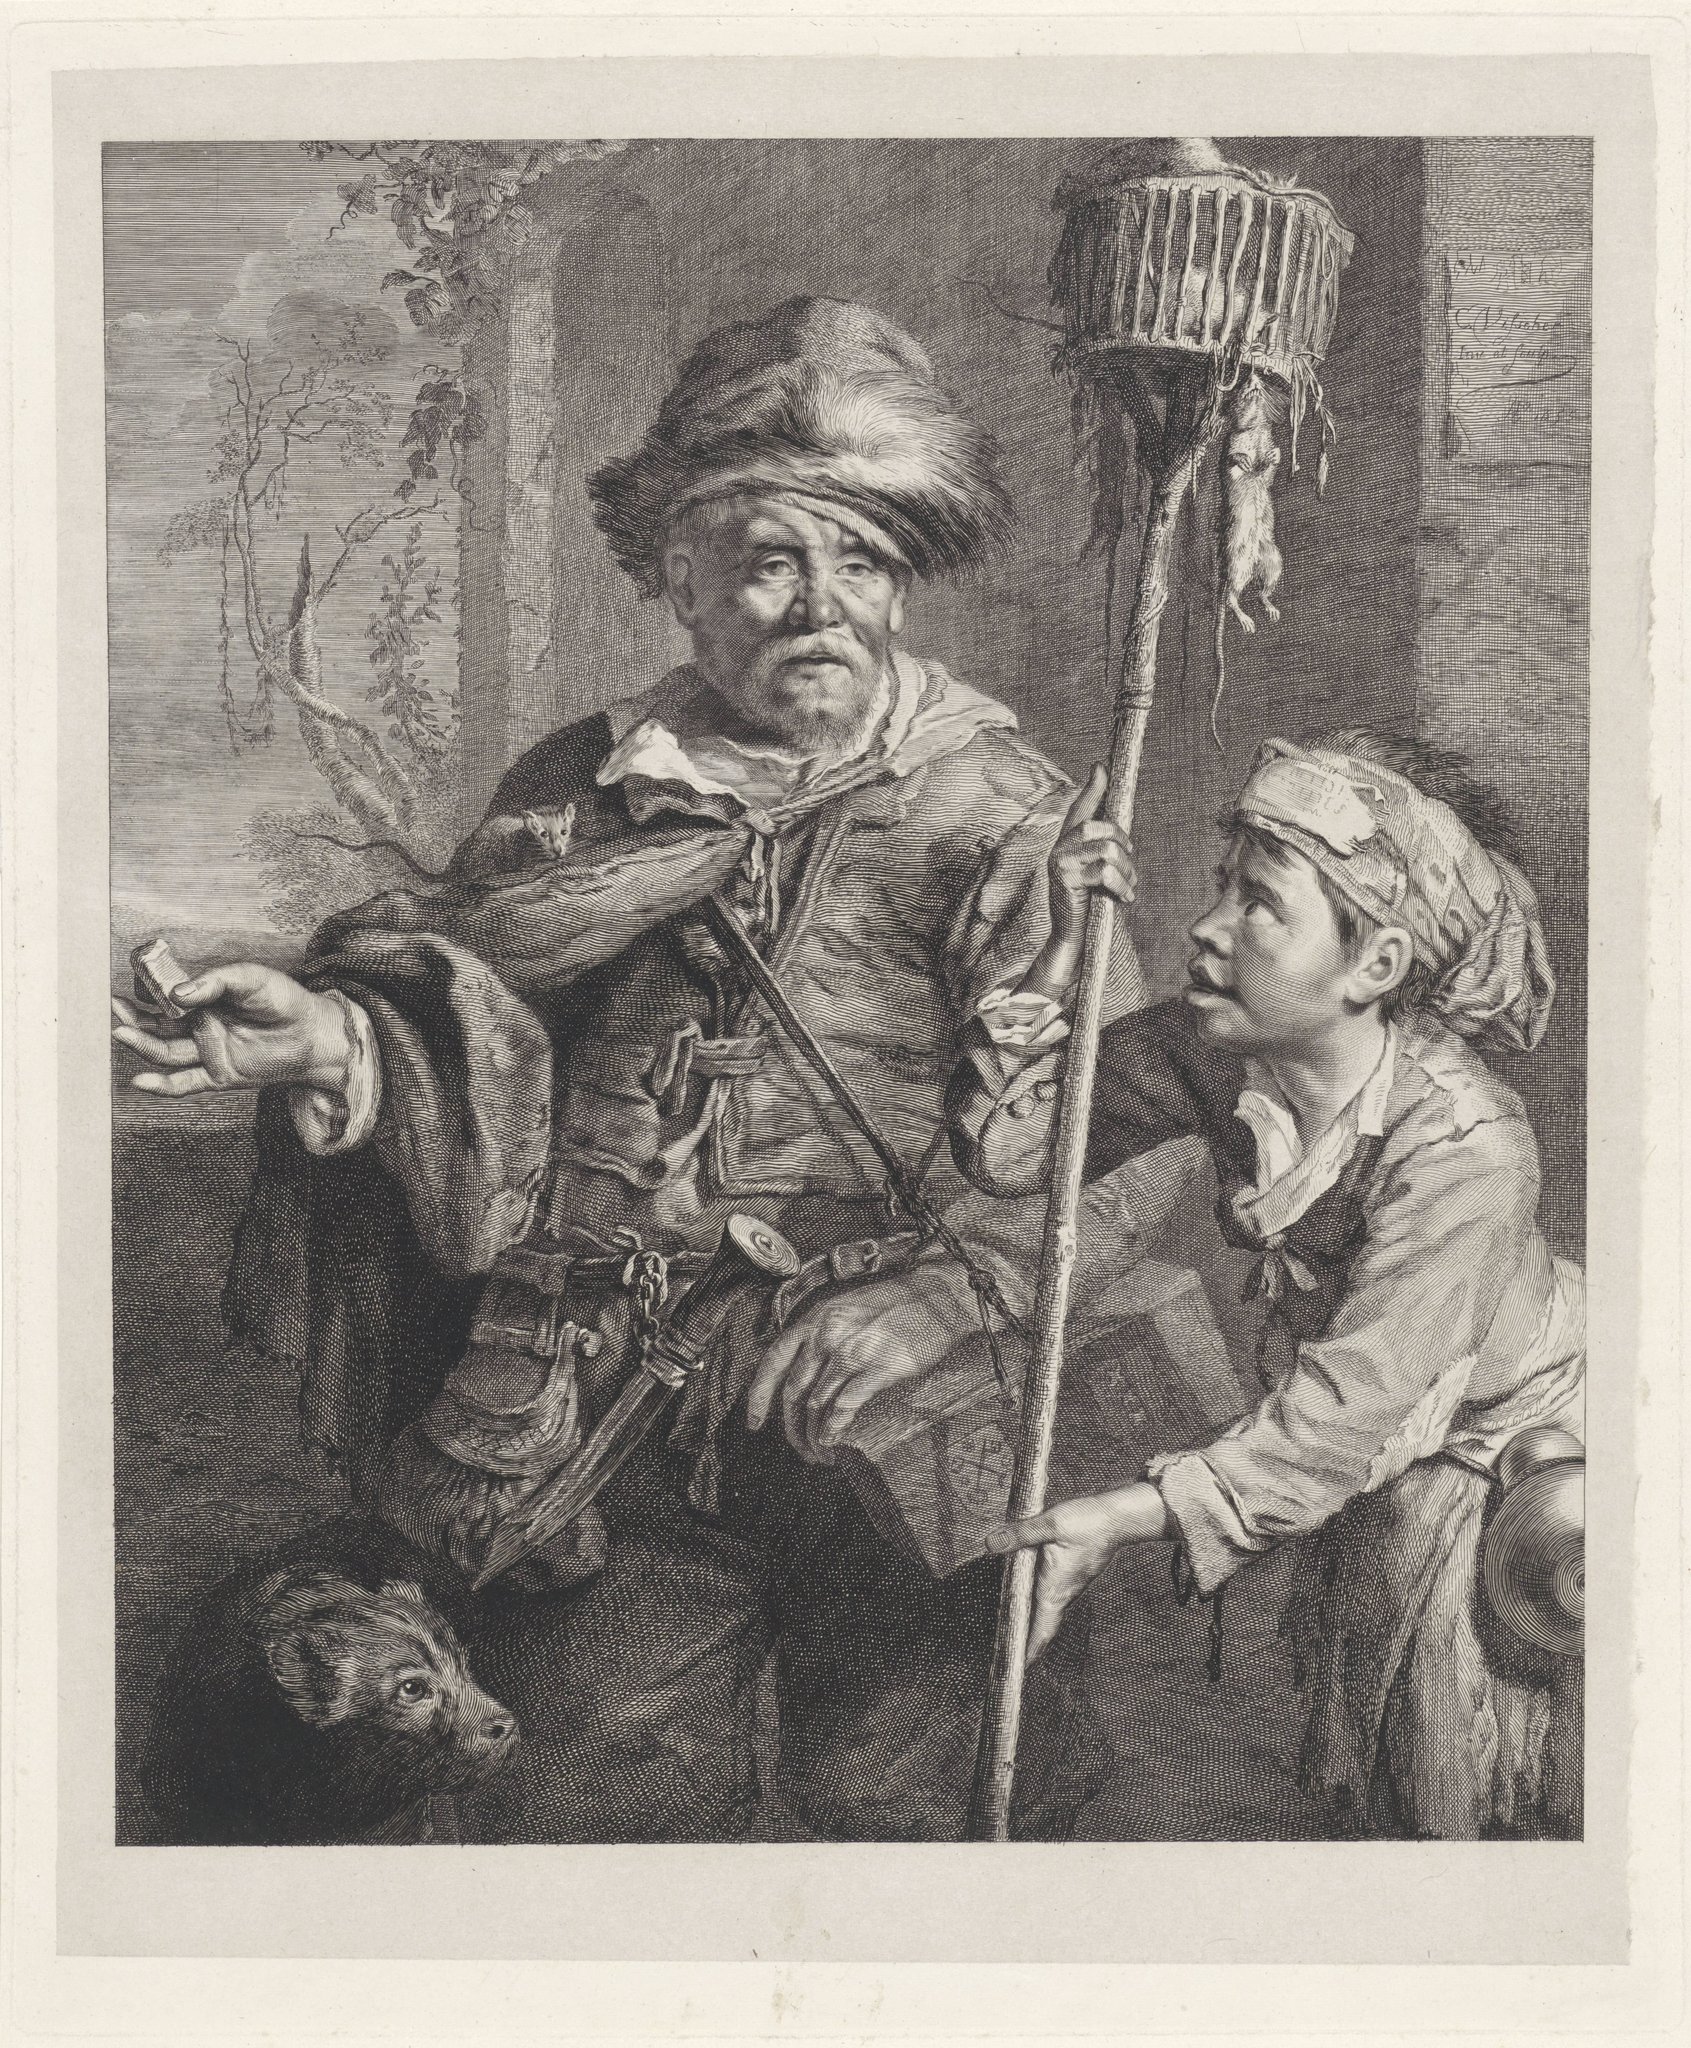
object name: print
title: De rattenvanger met zijn knecht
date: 1826-1886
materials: paper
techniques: engraving, etching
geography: amsterdam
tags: rat exterminator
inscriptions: collector's mark: Lugt 2228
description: Een rattenvanger met zijn hond en knecht. De jongen houdt een staf met een rattenkooi vast. De rattenvanger draagt een tas en gereedschap met zich mee, op zijn mantel loopt een rat. Op een kist die hij op zijn heup draagt staan de wapens van Leiden en Amsterdam.